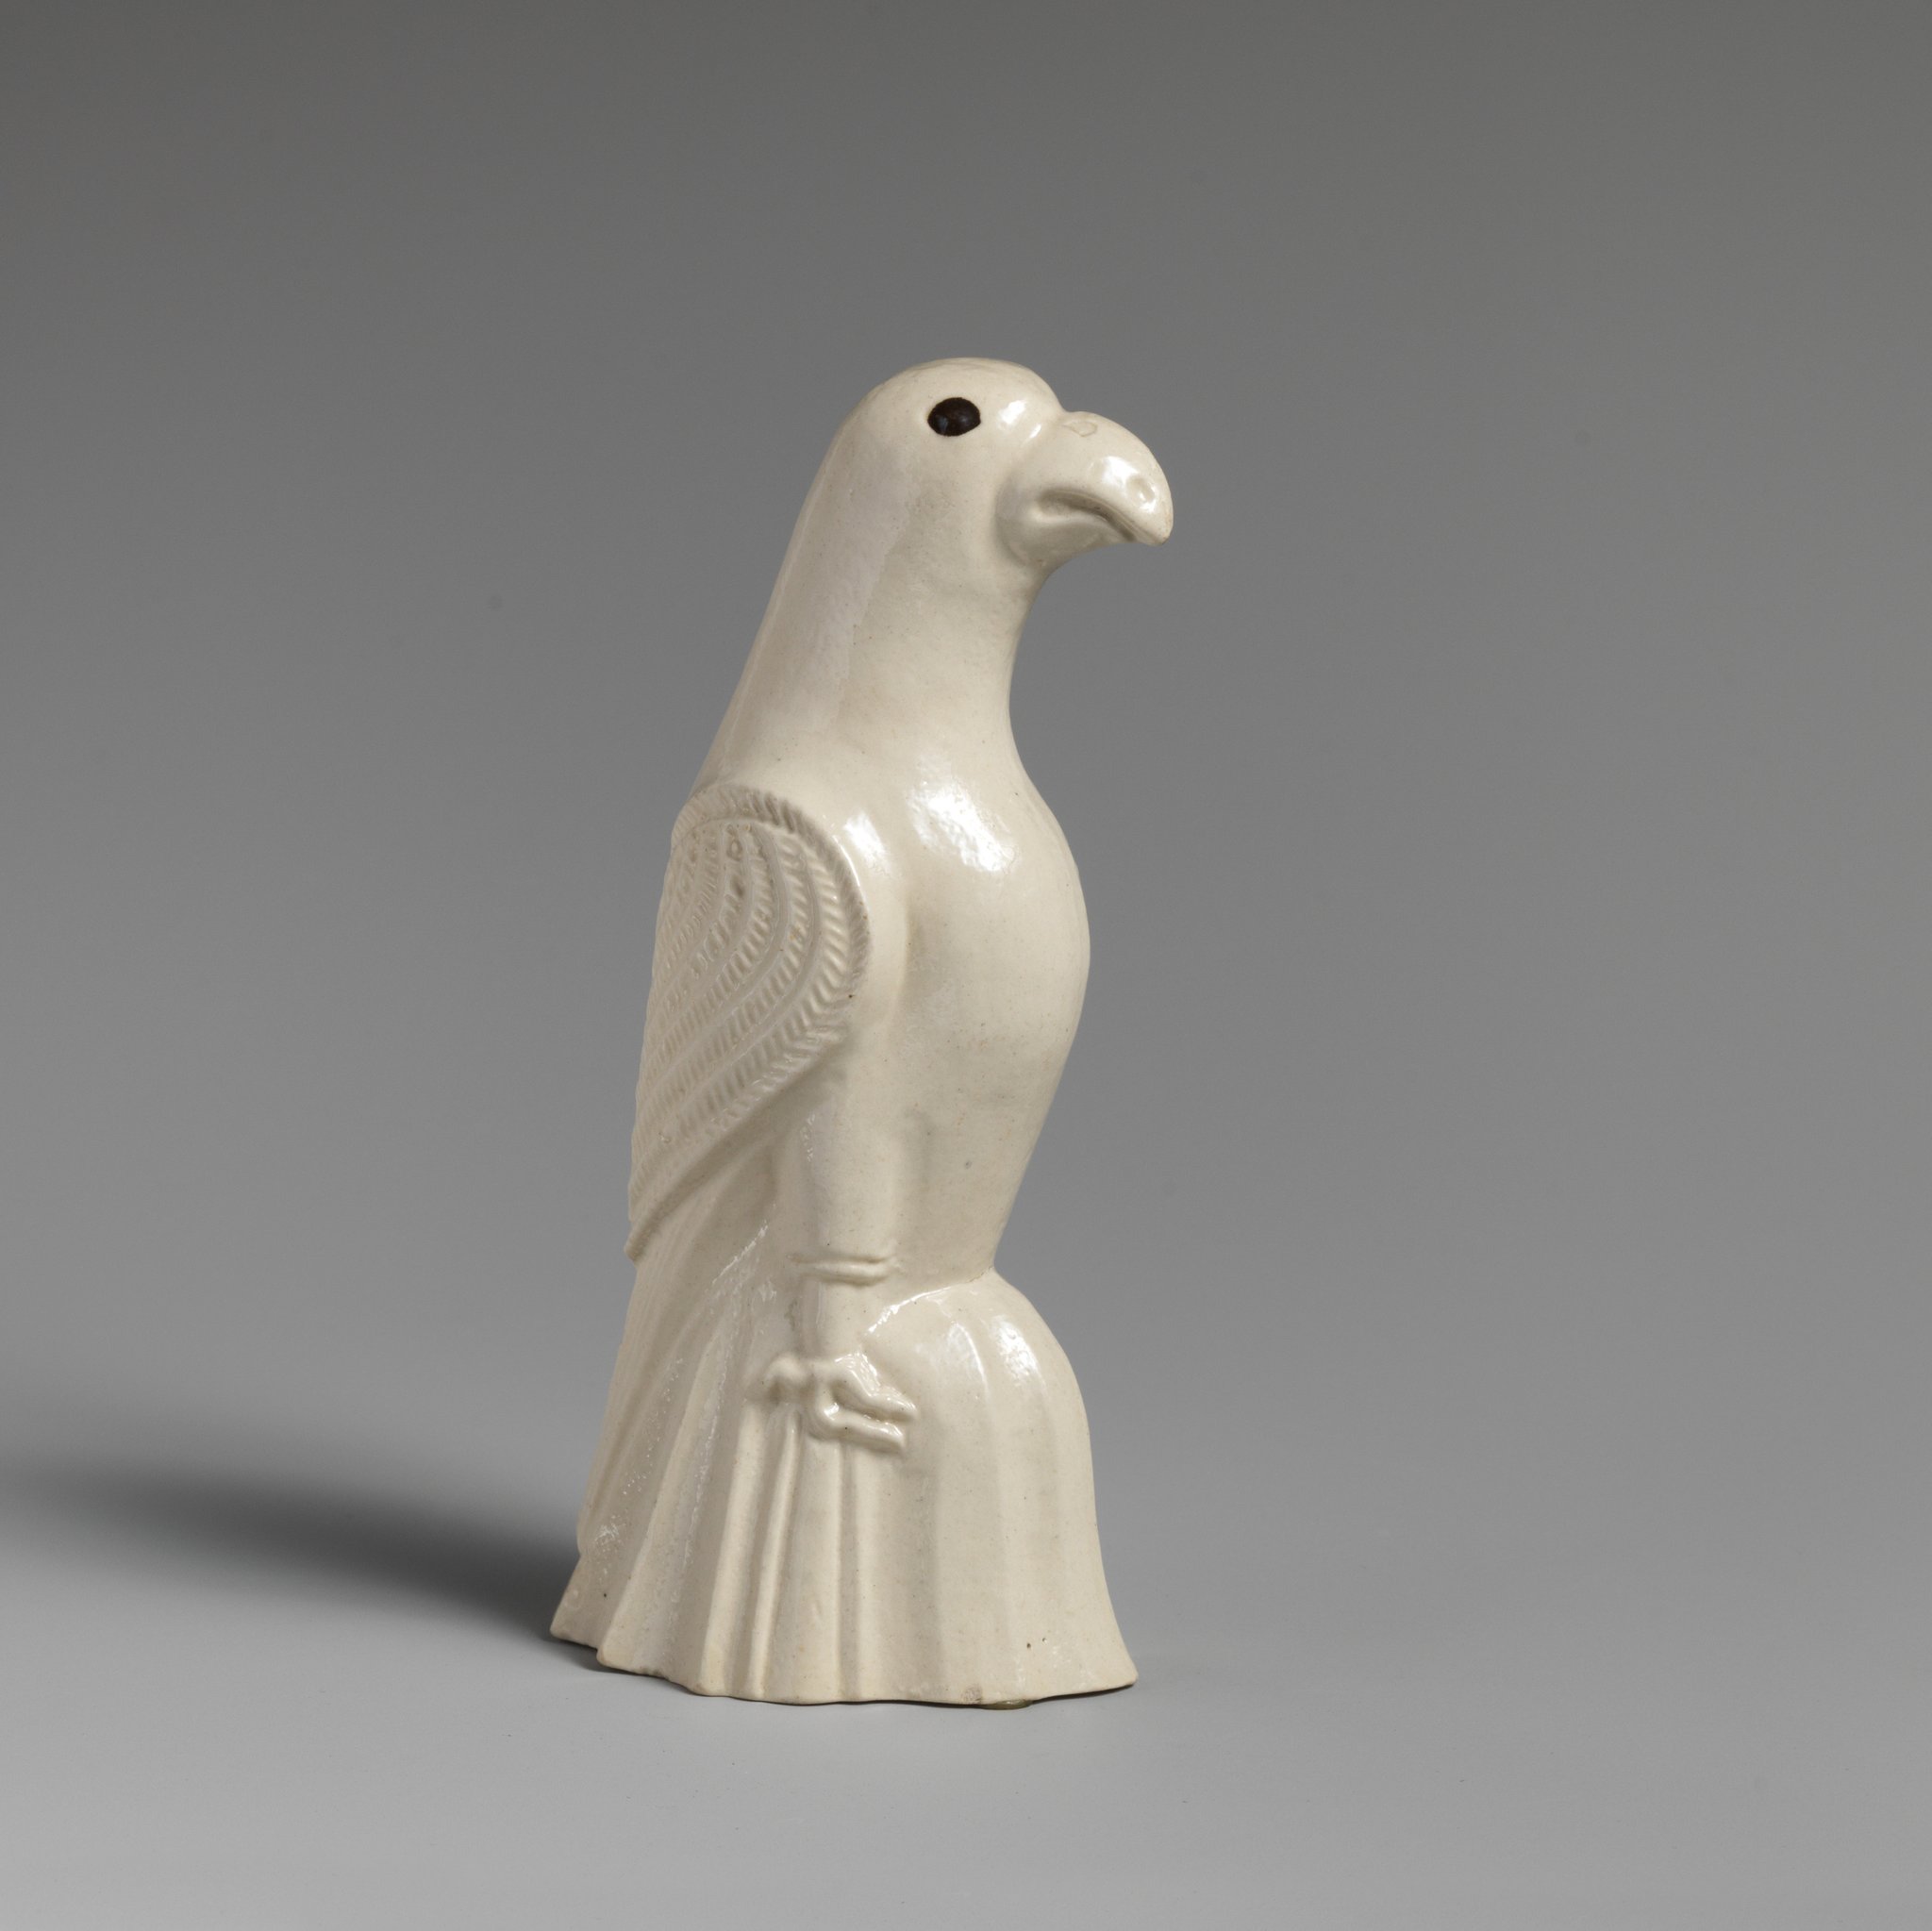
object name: figure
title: Parrot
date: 1745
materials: stoneware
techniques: salt glaze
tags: parrots